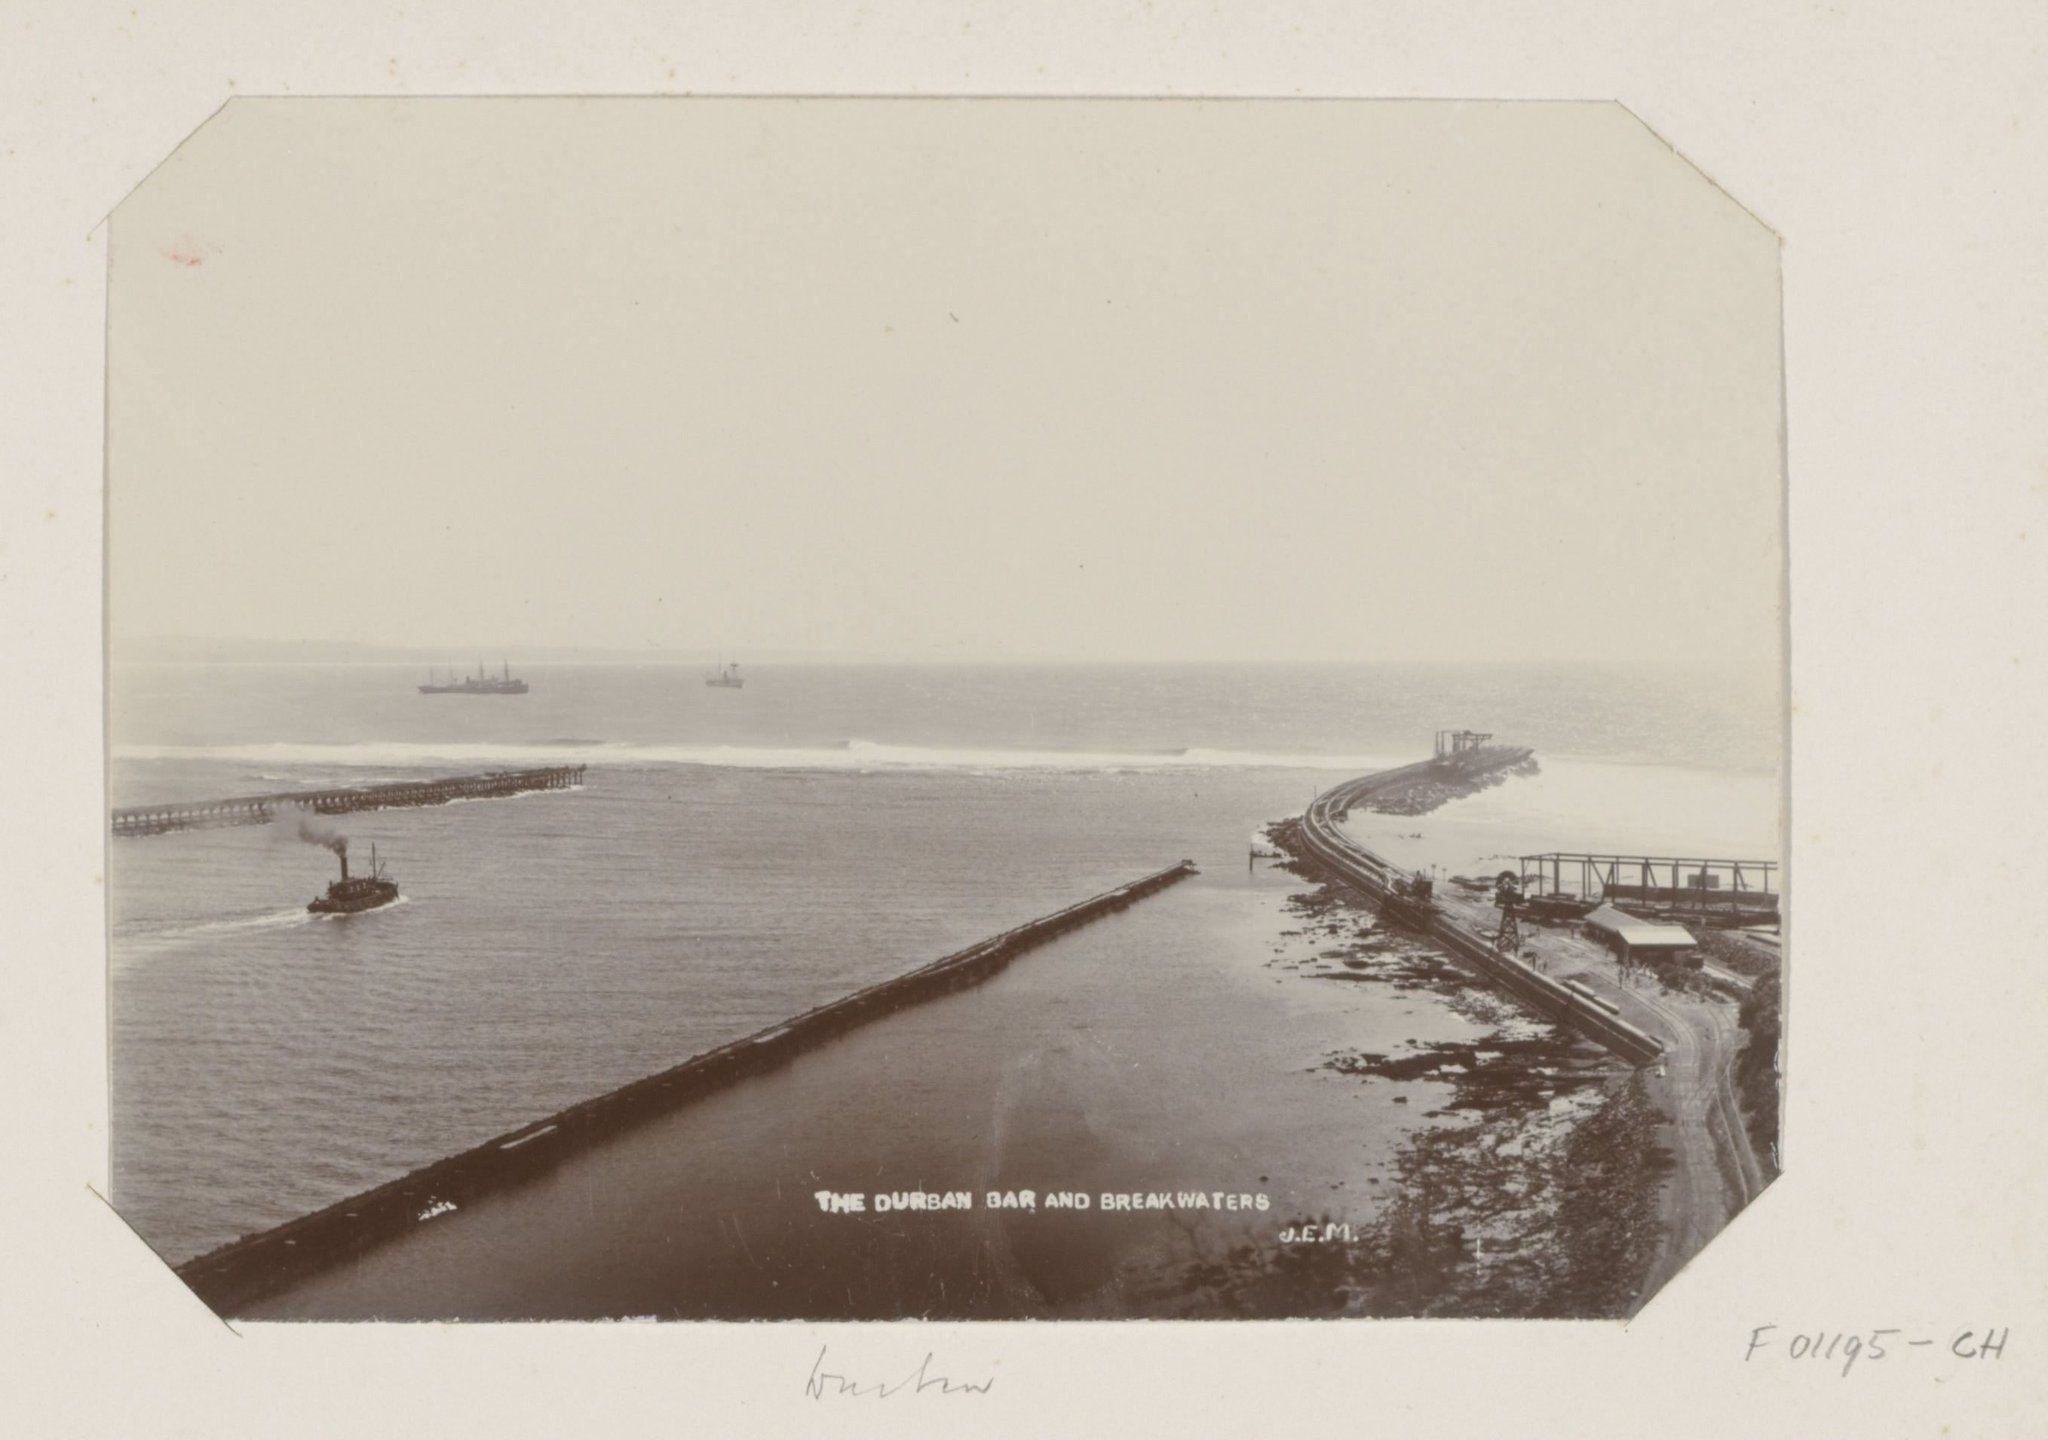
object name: photograph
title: The Durban Bar and Breakwaters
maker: jem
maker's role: fotograaf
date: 1880-1910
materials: cardboard, paper, photographic support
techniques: gelatin silver print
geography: durban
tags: harbour, coastal protection work, breakwater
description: Onderdeel van Fotoalbum van een reis door de Verenigde Staten, Honolulu, Nederlands-Indië, Aden, Zanzibar en Zuidelijk Afrika.